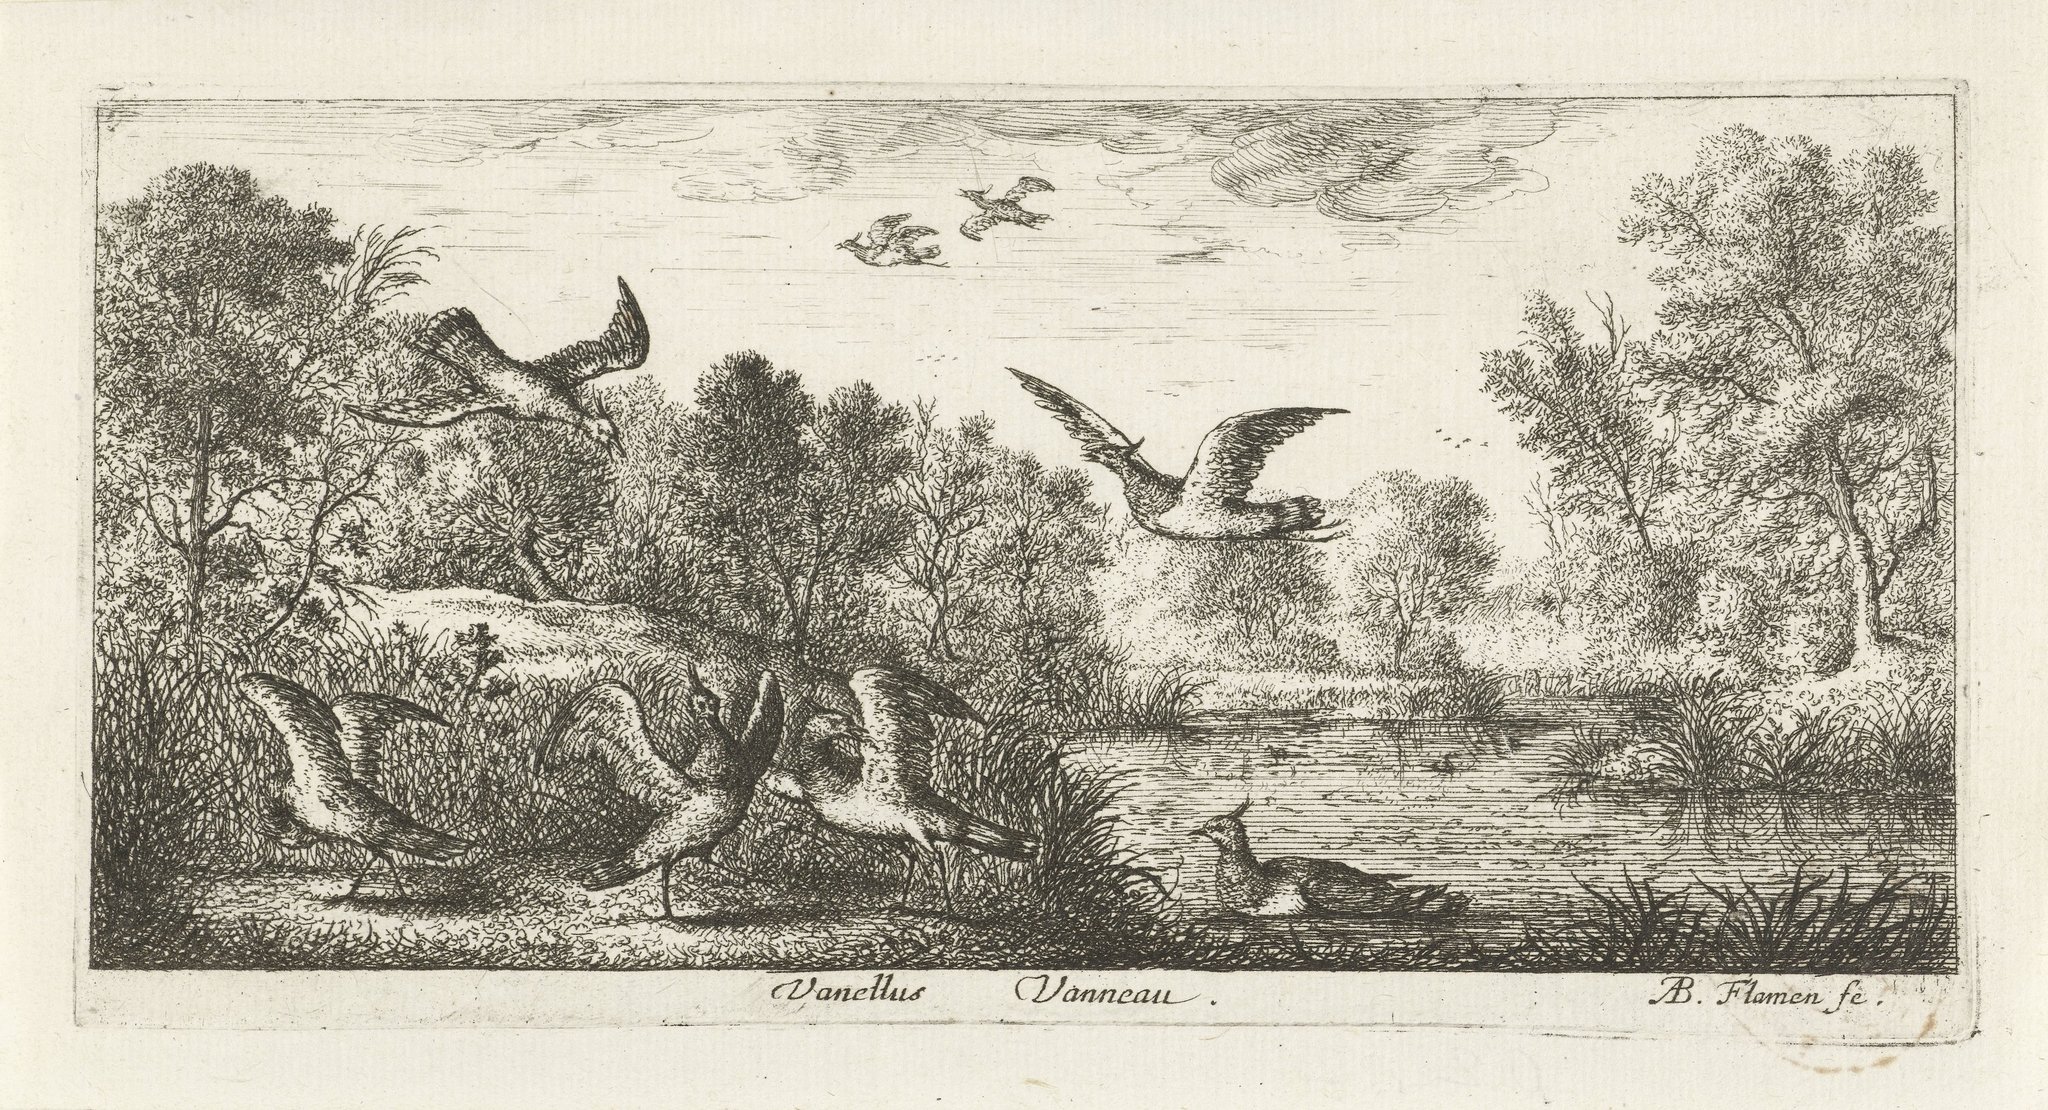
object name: print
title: Landschap met kievitten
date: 1648-1692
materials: paper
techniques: etching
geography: france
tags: shore-birds and wading-birds: lapwing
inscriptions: collector's mark: Lugt 240